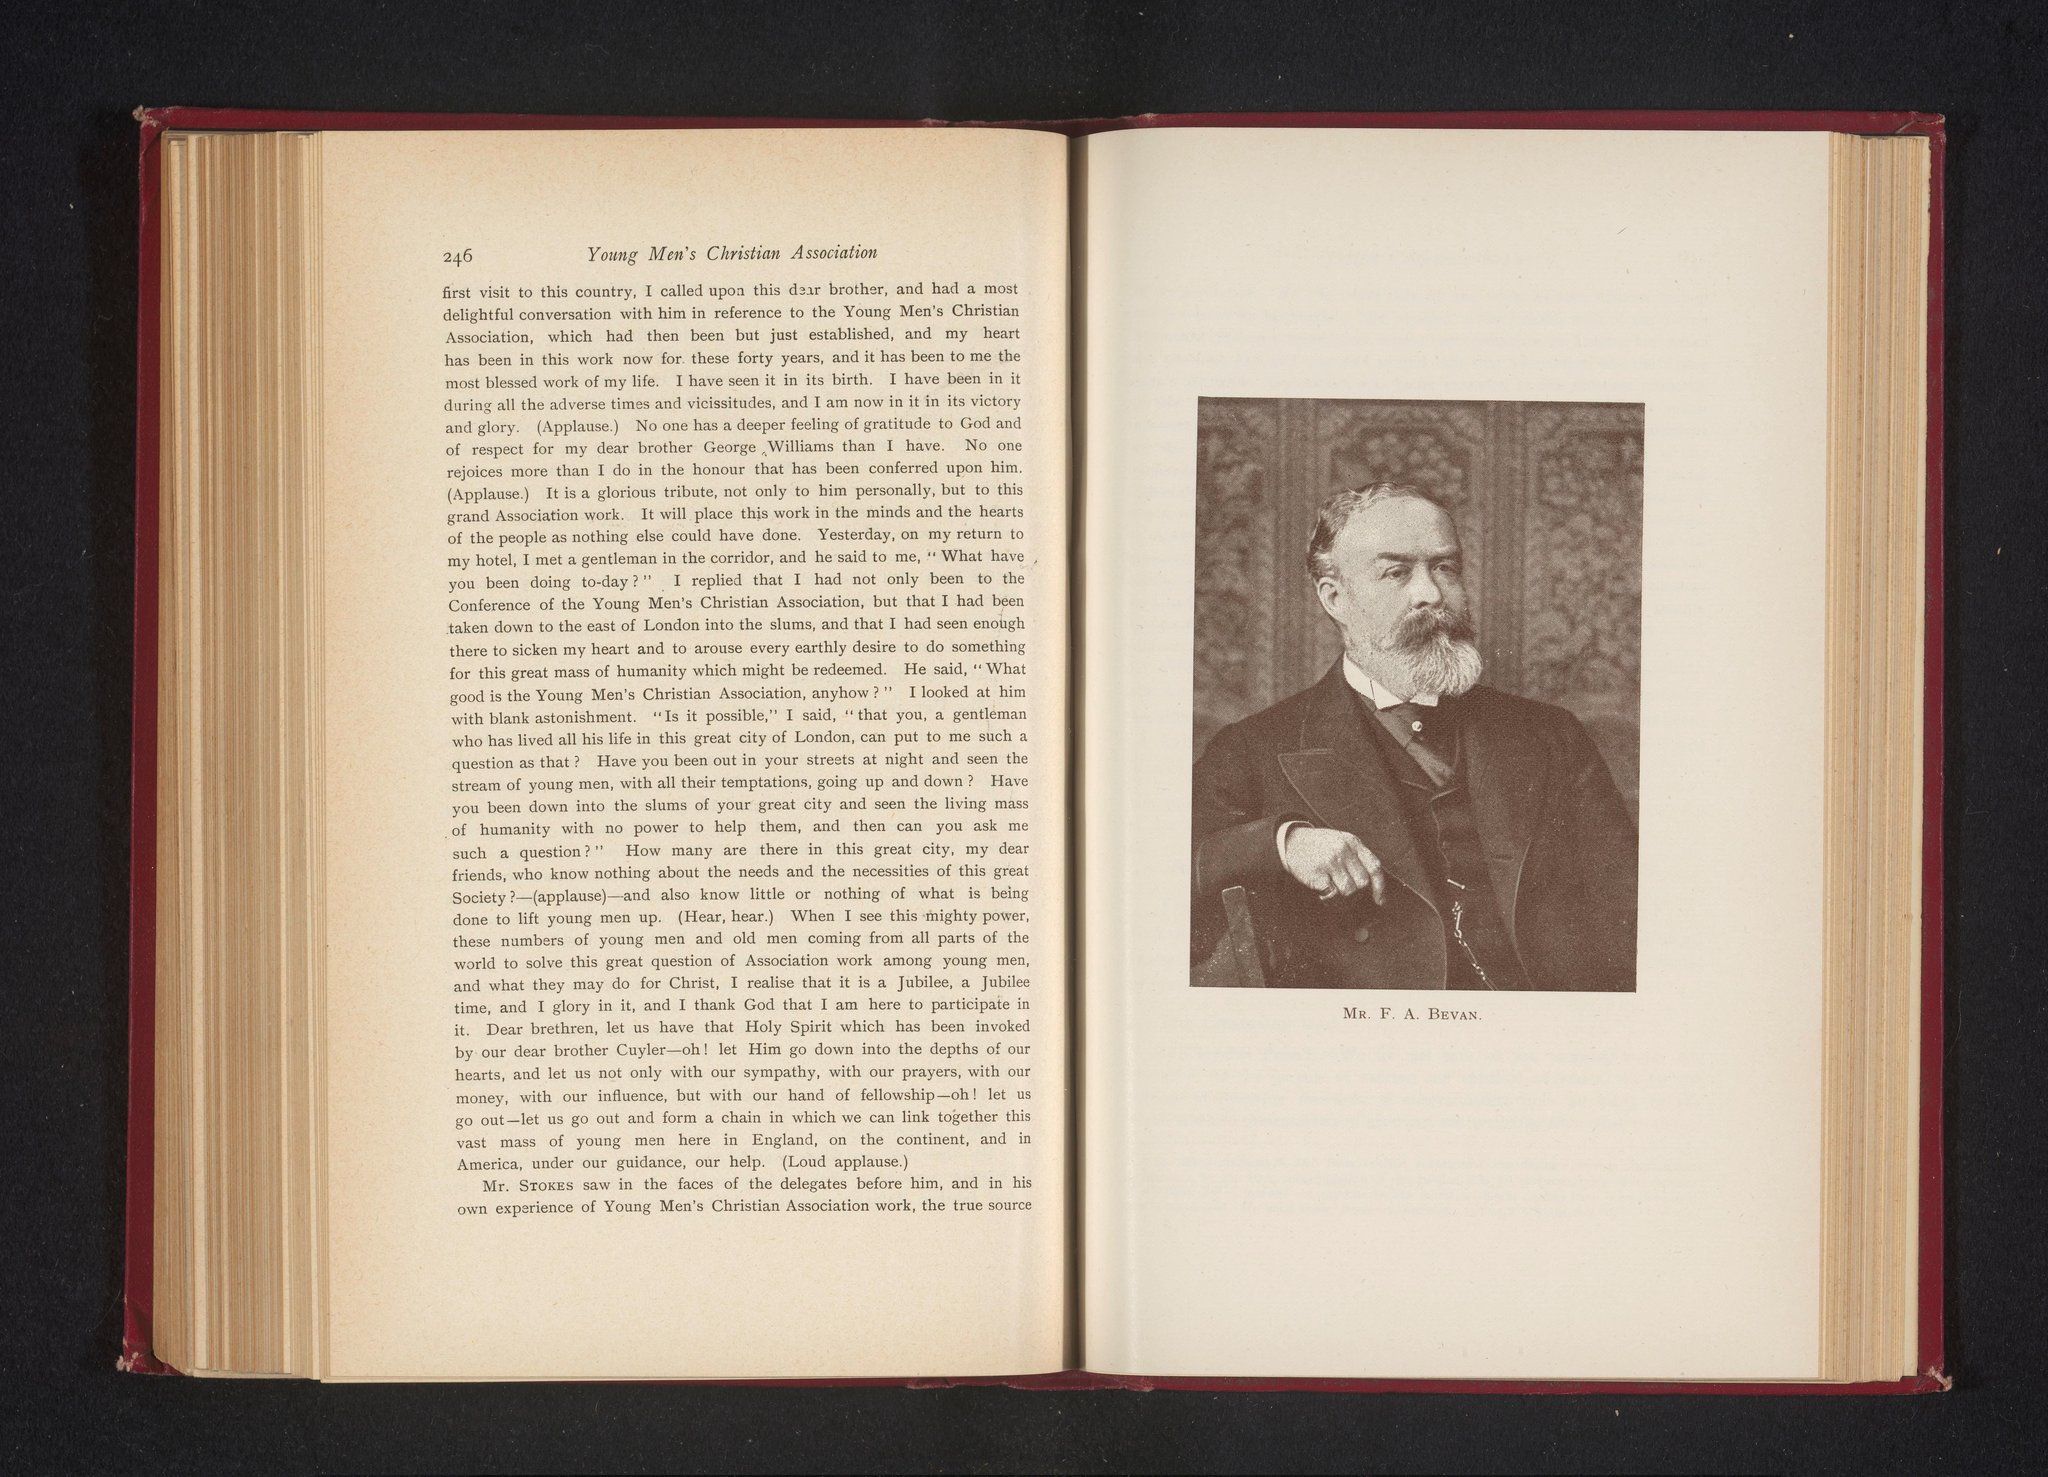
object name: page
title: Mr. F. A. Bevan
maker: Anonymous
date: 1890-1895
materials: paper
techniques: autotype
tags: historical persons